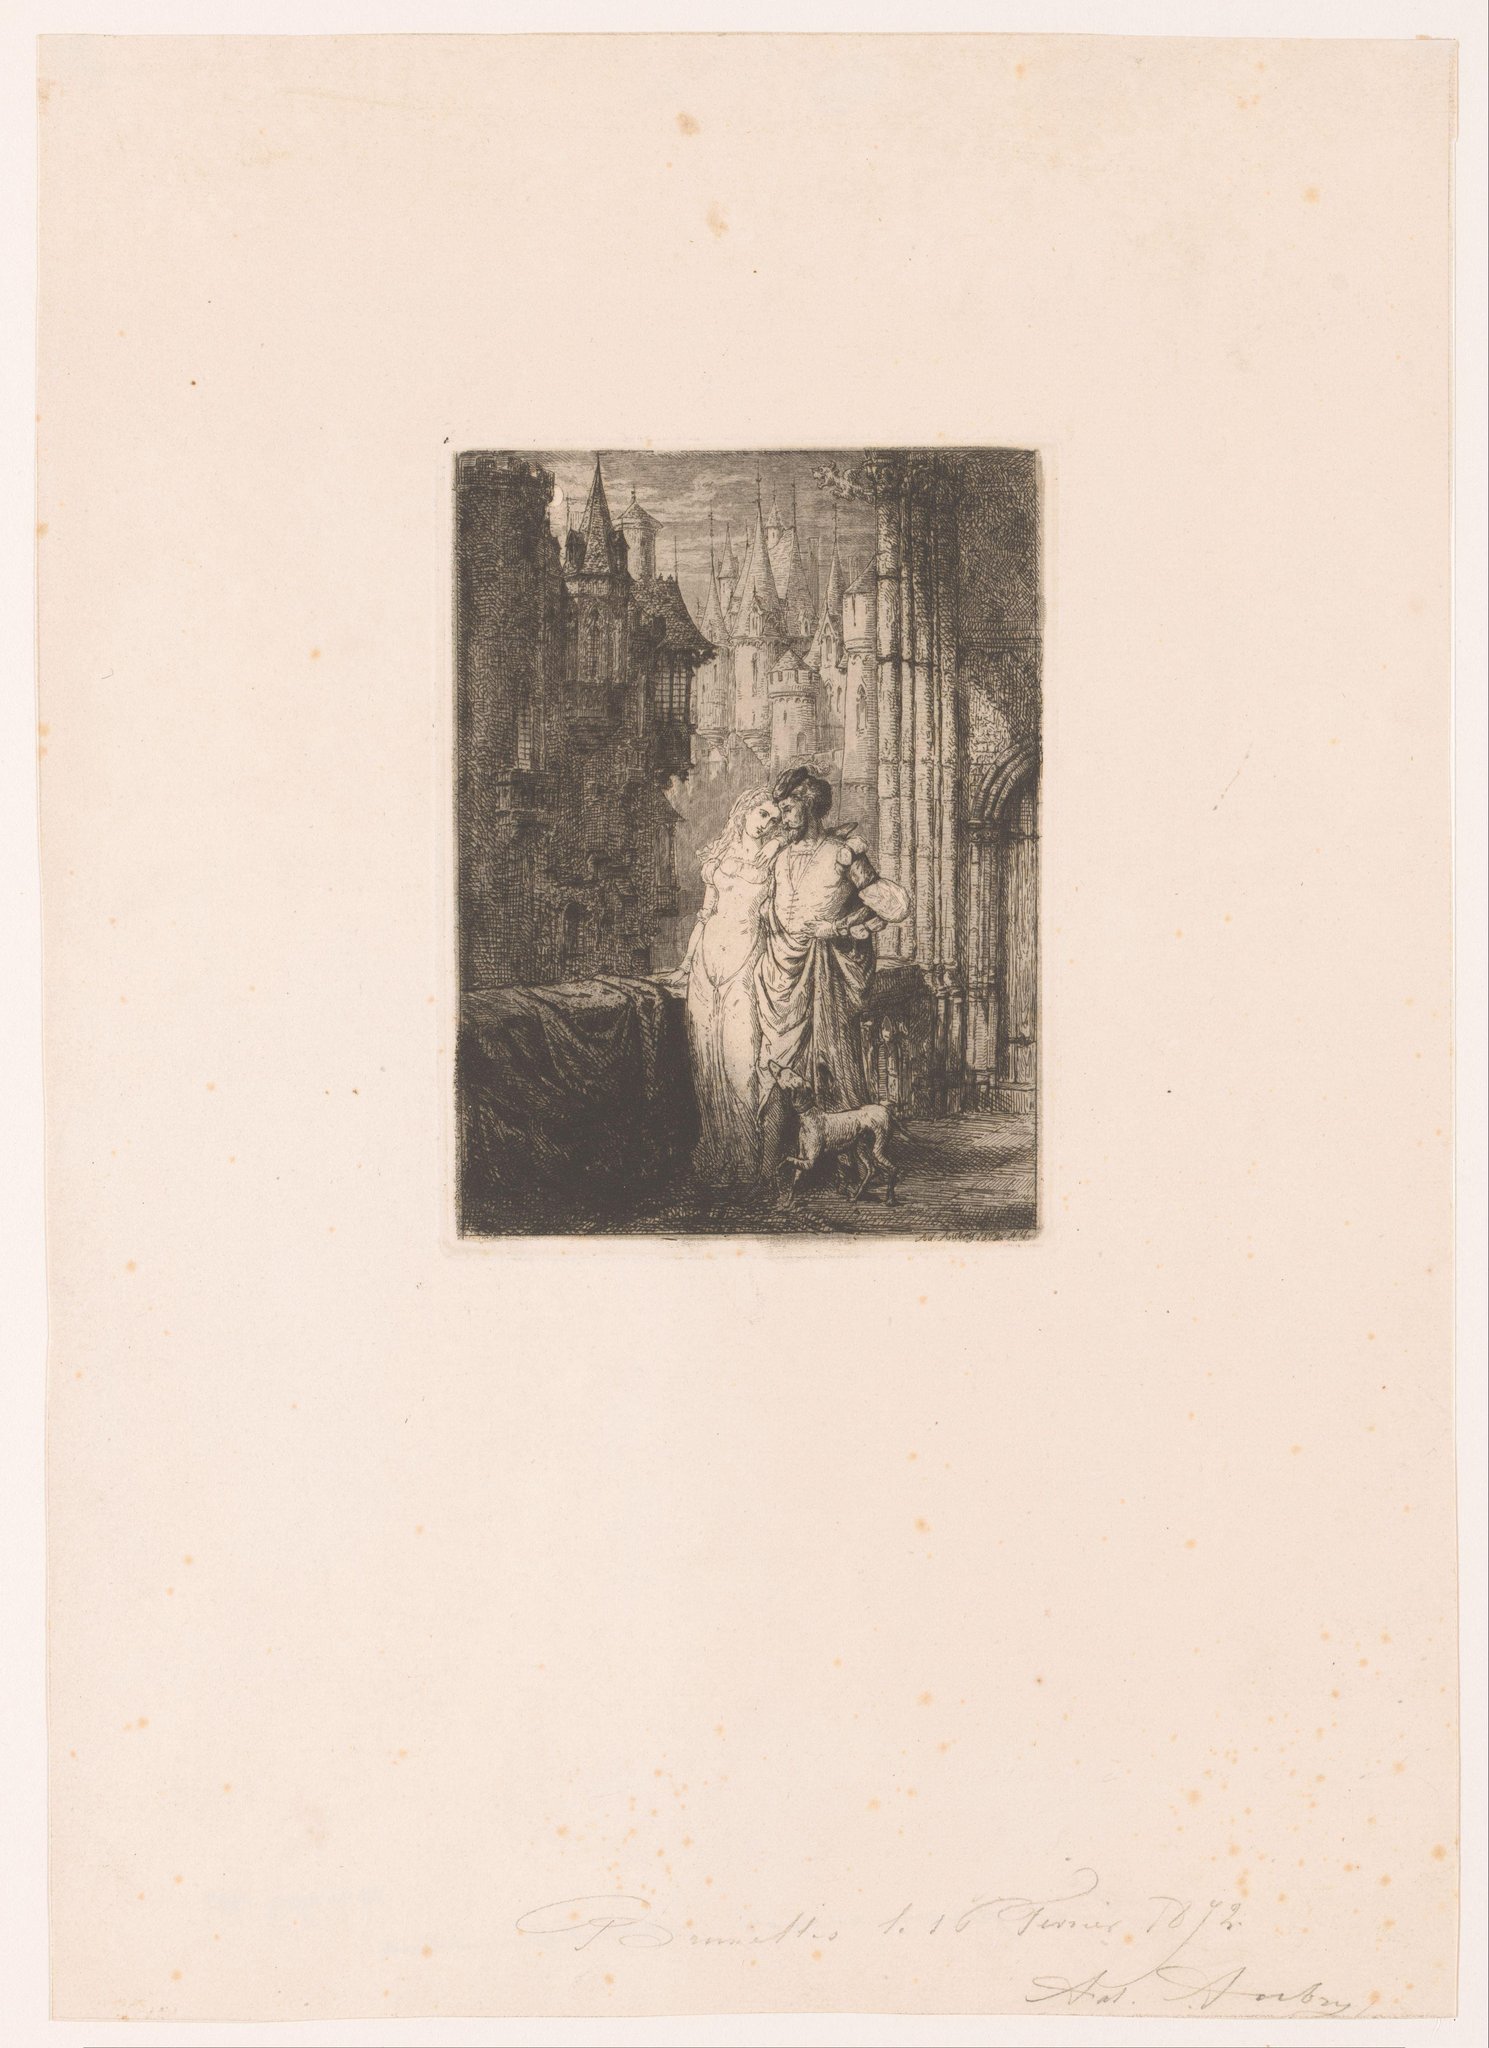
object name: print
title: Minnend paar wandelt in een middeleeuwse stad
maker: adrien aubry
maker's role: painter, print maker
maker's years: 1834-1889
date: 1872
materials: paper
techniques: etching, intaglio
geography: brussels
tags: prospect of city, town panorama, silhouette of city - ii - ideal city, arm in arm (lovers)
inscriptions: annotation: ‘Bruxelles le 16 Fevrier 1872 / Ad. Aubry’, watermark: ‘Hallines’